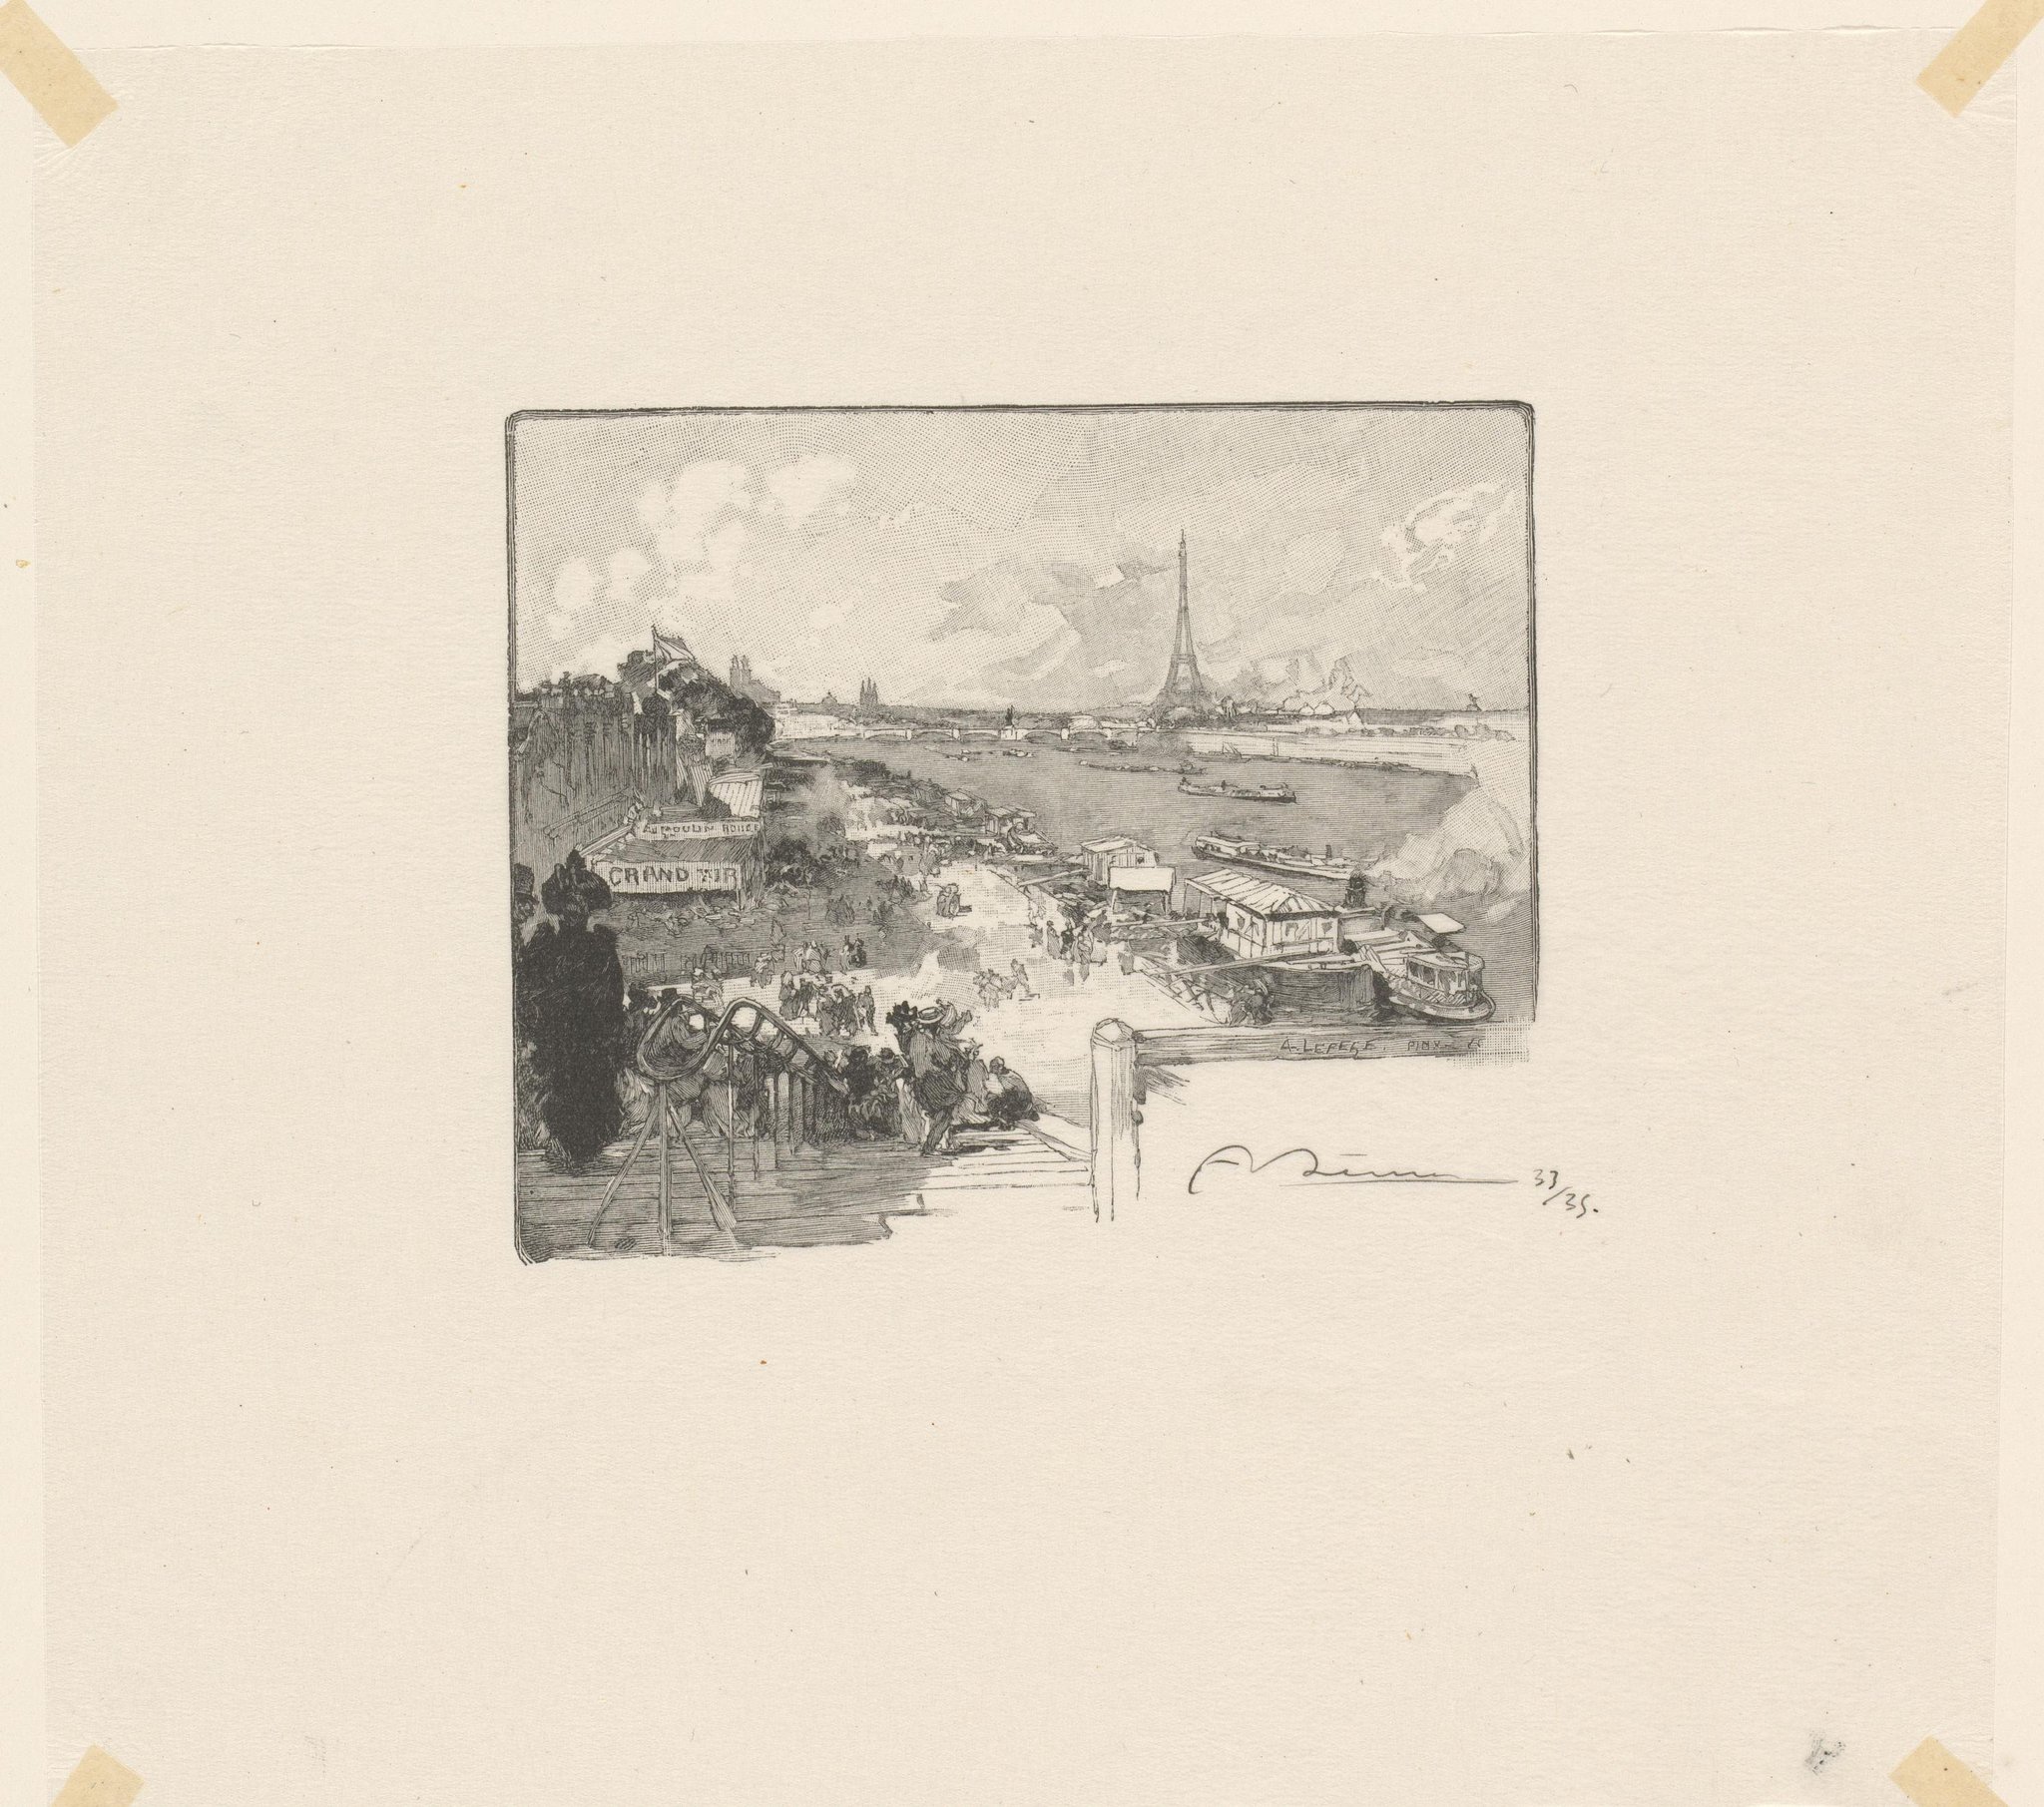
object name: print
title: Le long de la Seine et des boulevards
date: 1910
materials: paper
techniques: engraving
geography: paris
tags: bridge in city across river, canal, etc., prospect of city, town panorama, silhouette of city, paris, eiffel tower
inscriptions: collector's mark: Lugt 2228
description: Deze serie heeft als titel 'Le long de la Seine et des boulevards'. Deze serie is het vierde deel van het grotere geheel 'L'Oeuvre gravé sur bois de Auguste Lepère'.